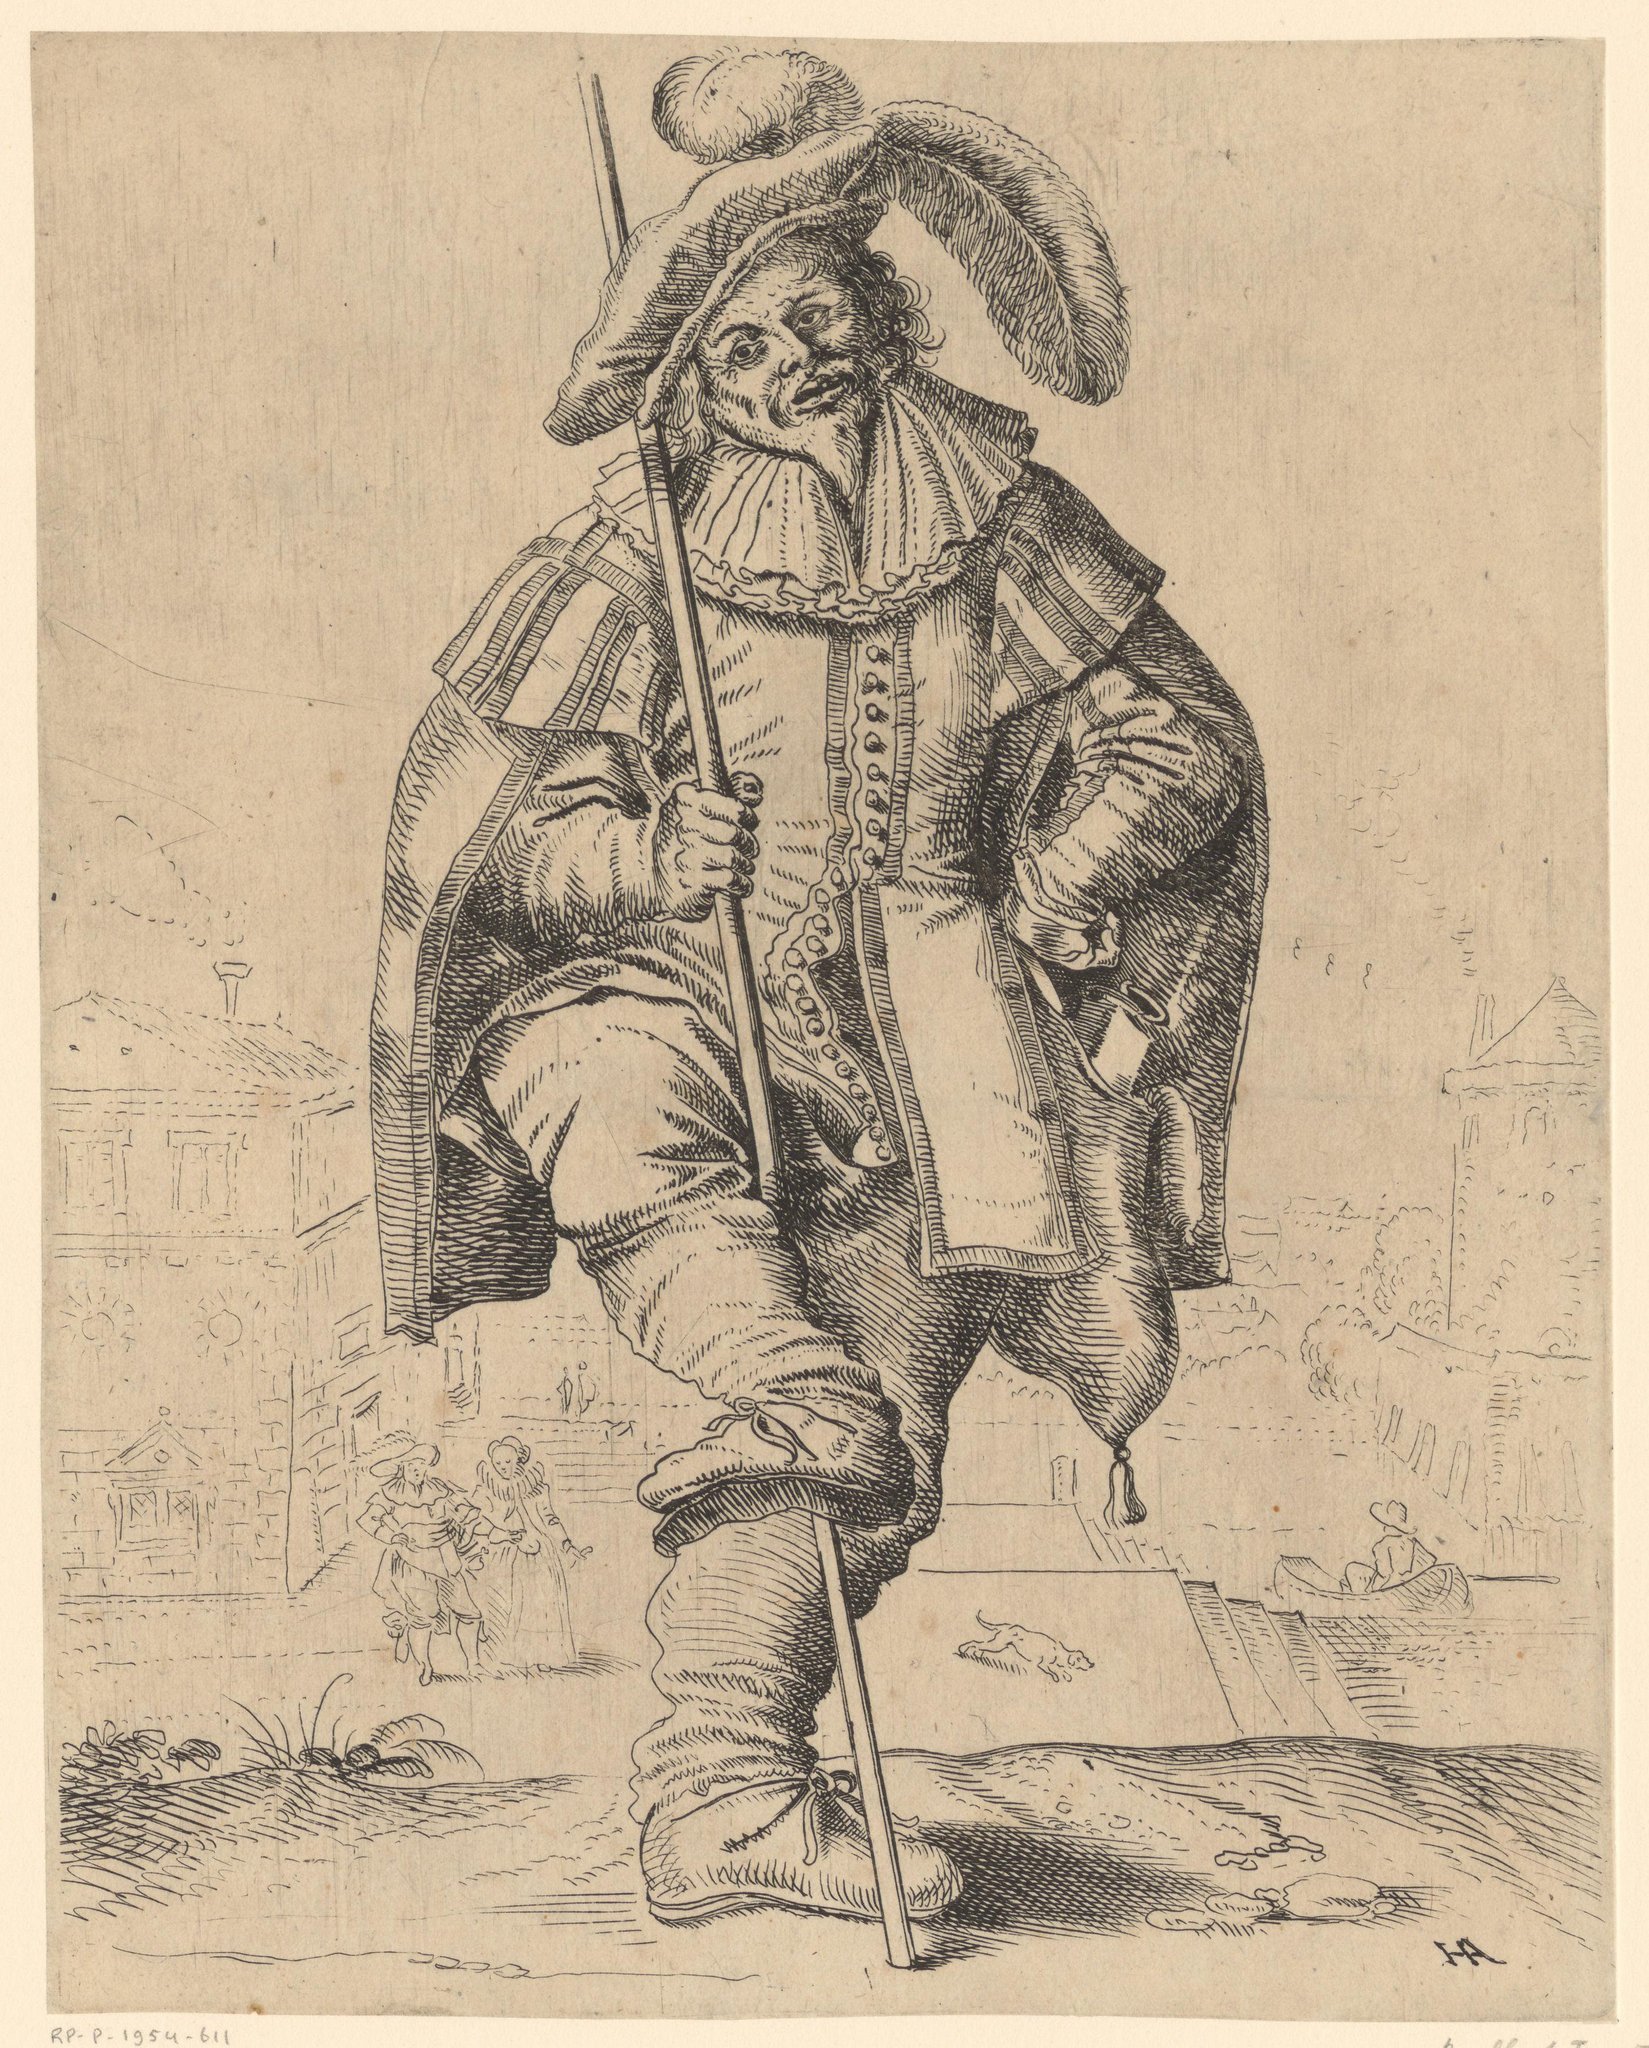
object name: print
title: Zelfportret als toneelspeler in de rol van Peter Leberwurst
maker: hans ammon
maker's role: print maker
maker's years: -1632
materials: paper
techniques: engraving, etching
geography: nuremberg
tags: print maker, hans ammon, portrait of artiste (dancer, actor, etc.), portrait, self-portrait of artist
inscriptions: collector's mark: Lugt 2760, collector's mark: Lugt 2228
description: Portret ten voeten uit, met staf, muts met veer en opgetrokken been.